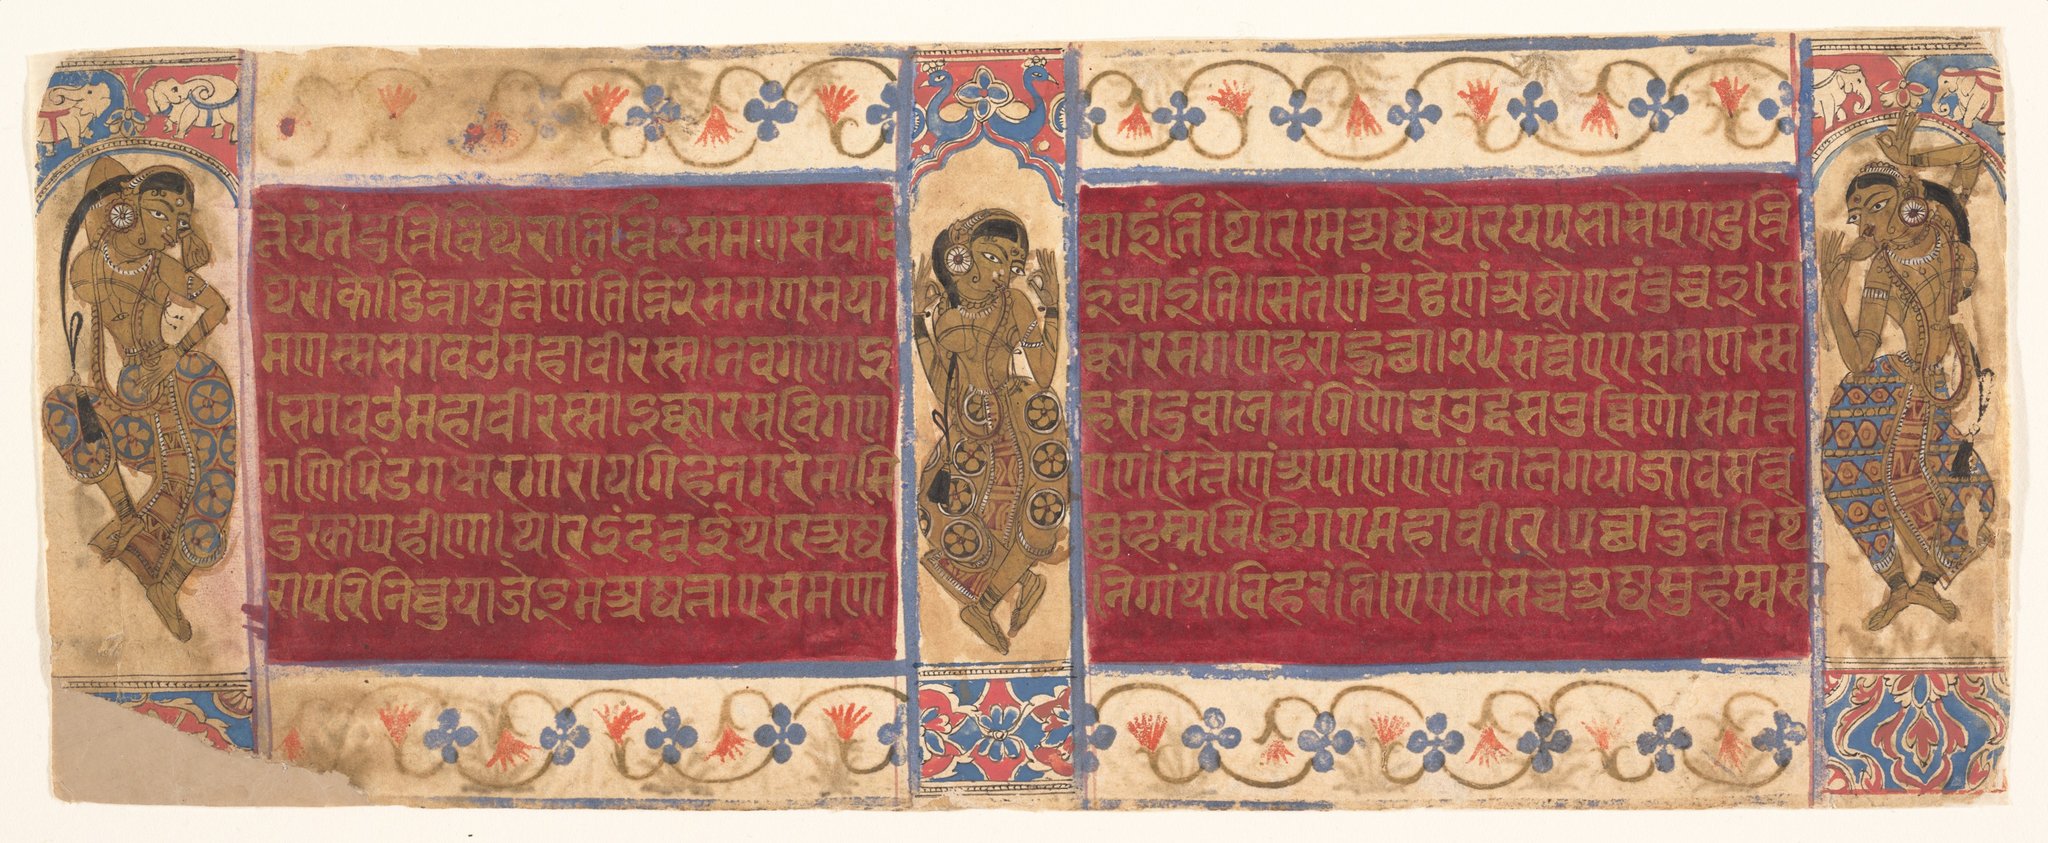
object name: folio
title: Celestial Performers: Folios from a Kalpasutra Manuscript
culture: indian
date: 1490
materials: ink, paper, watercolor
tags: women